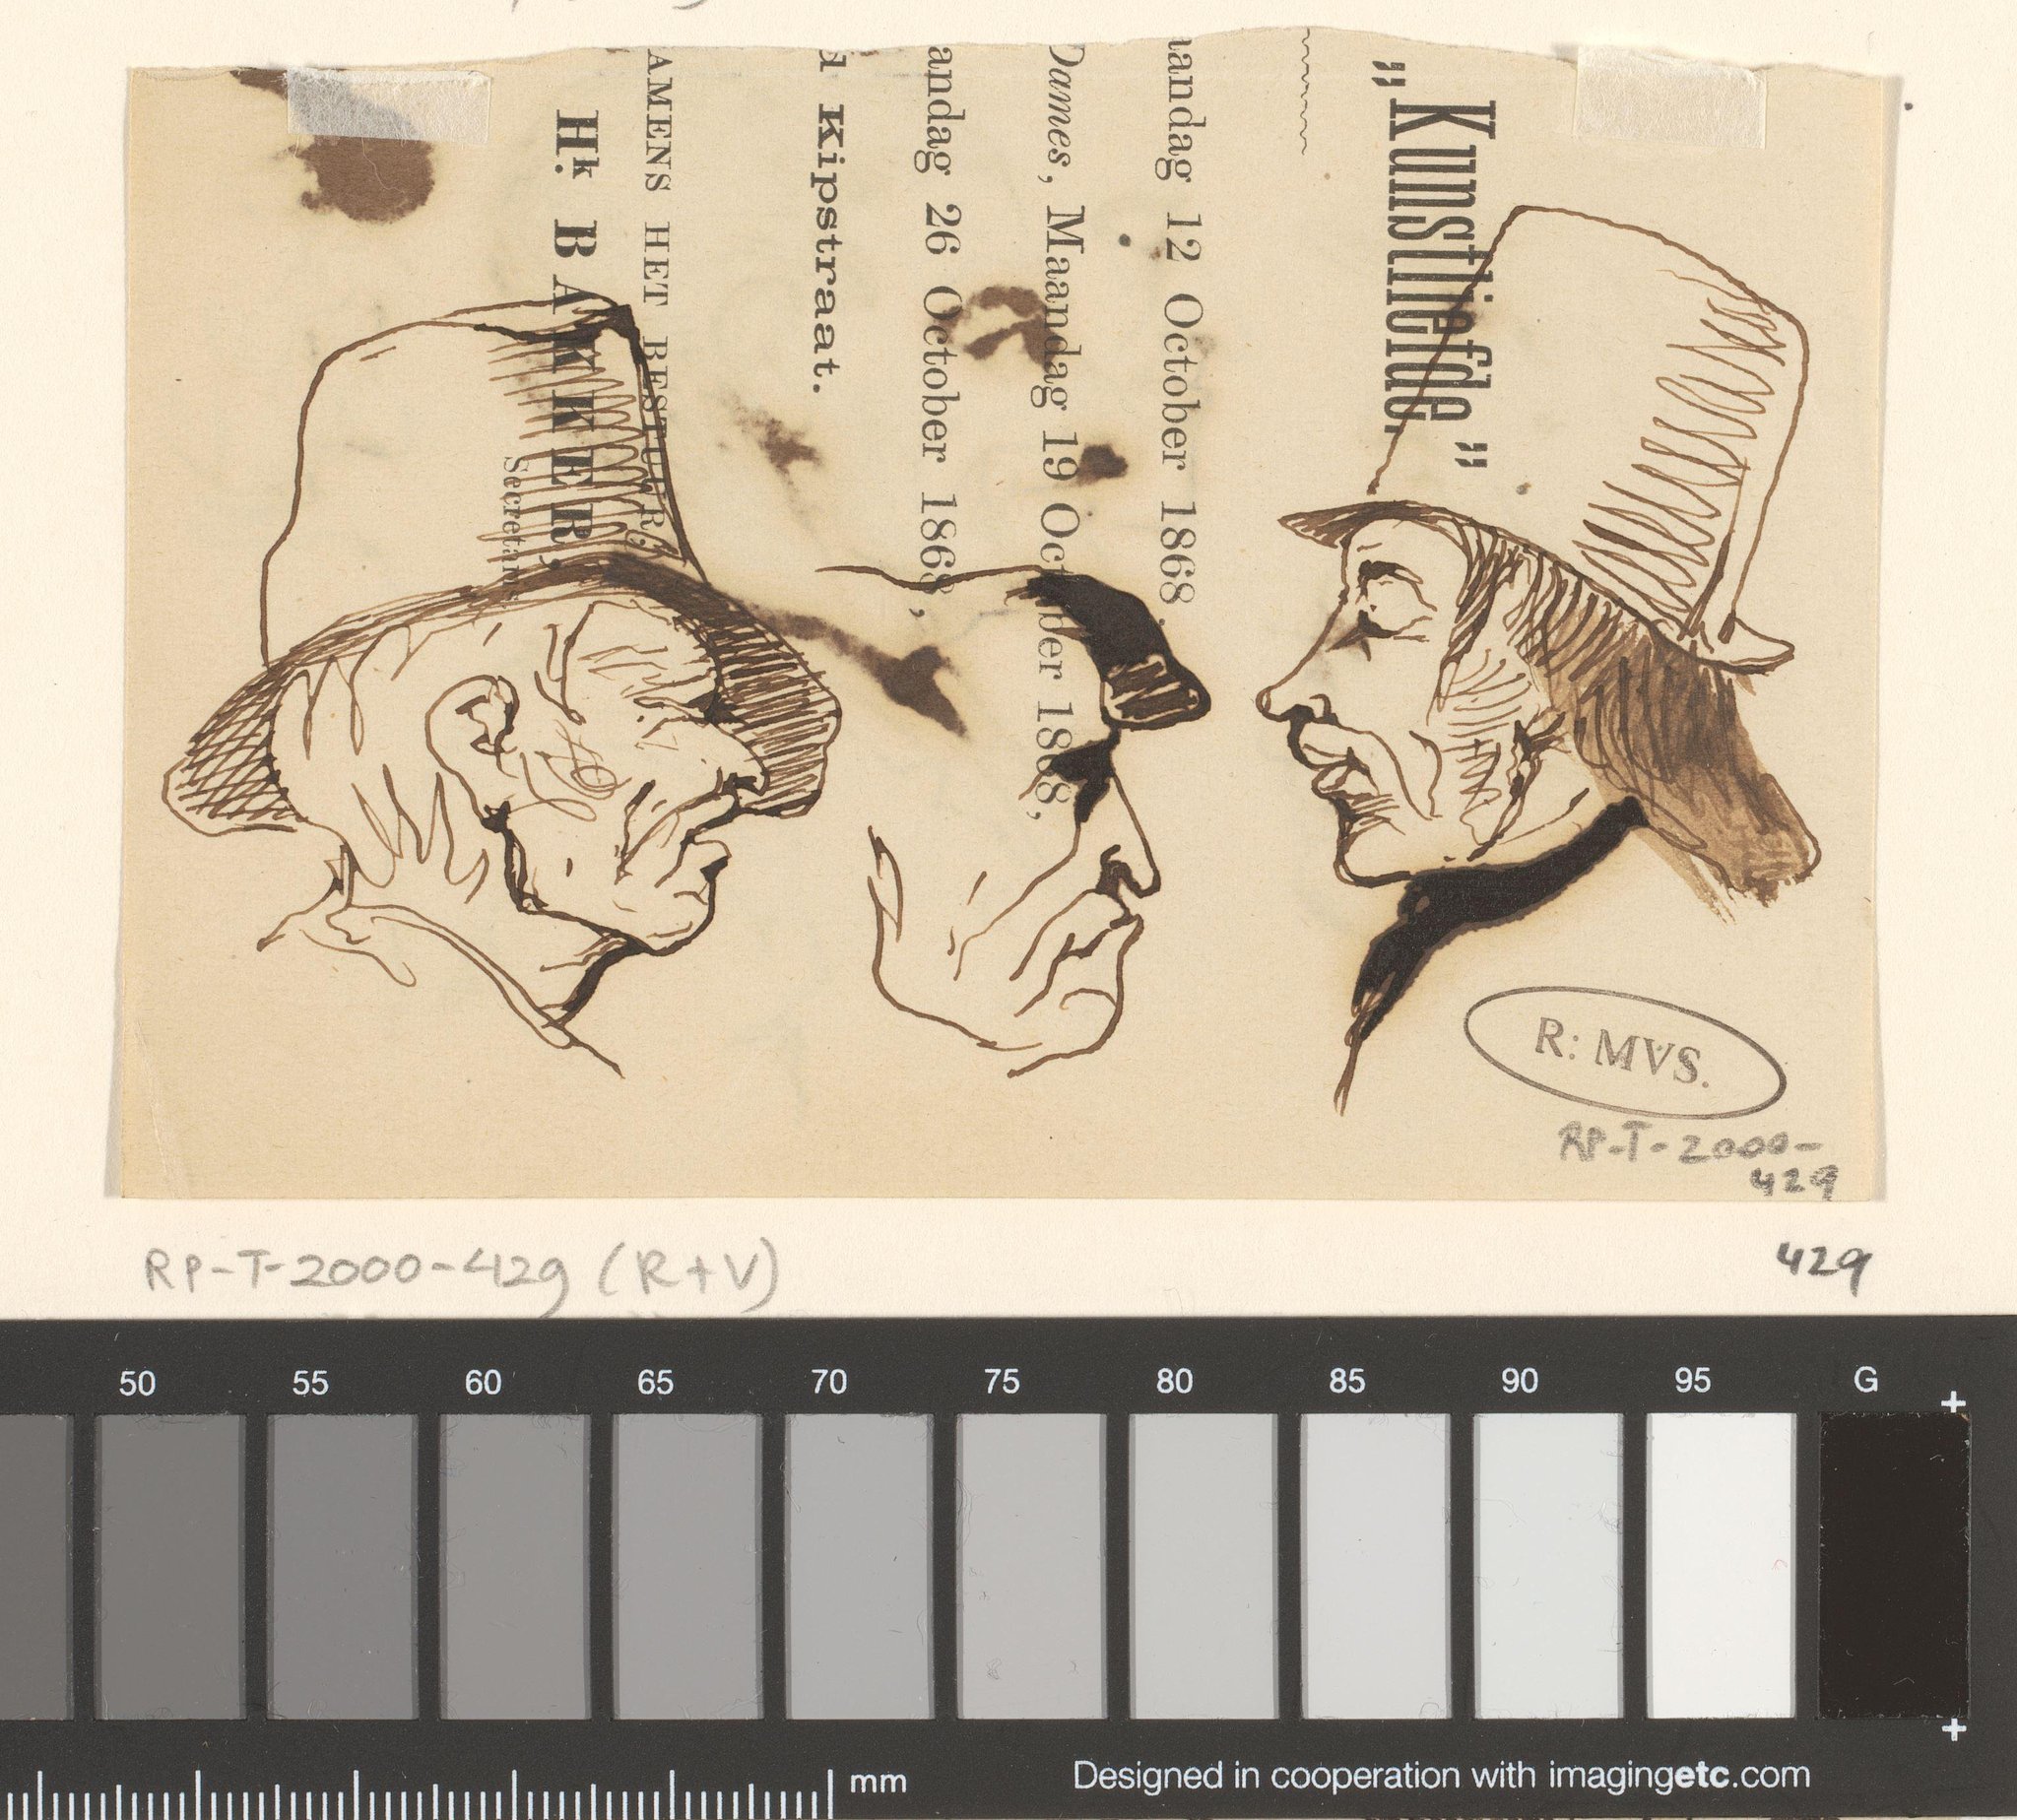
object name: drawing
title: Koppen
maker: johannes tavenraat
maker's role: draughtsman, painter, print maker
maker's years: 1809-1881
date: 1868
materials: ink, paper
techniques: brush, pen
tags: caricatures (human types)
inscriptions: collector's mark: Lugt 2228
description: Drie koppen. Getekend op een drukwerk uit 1868.